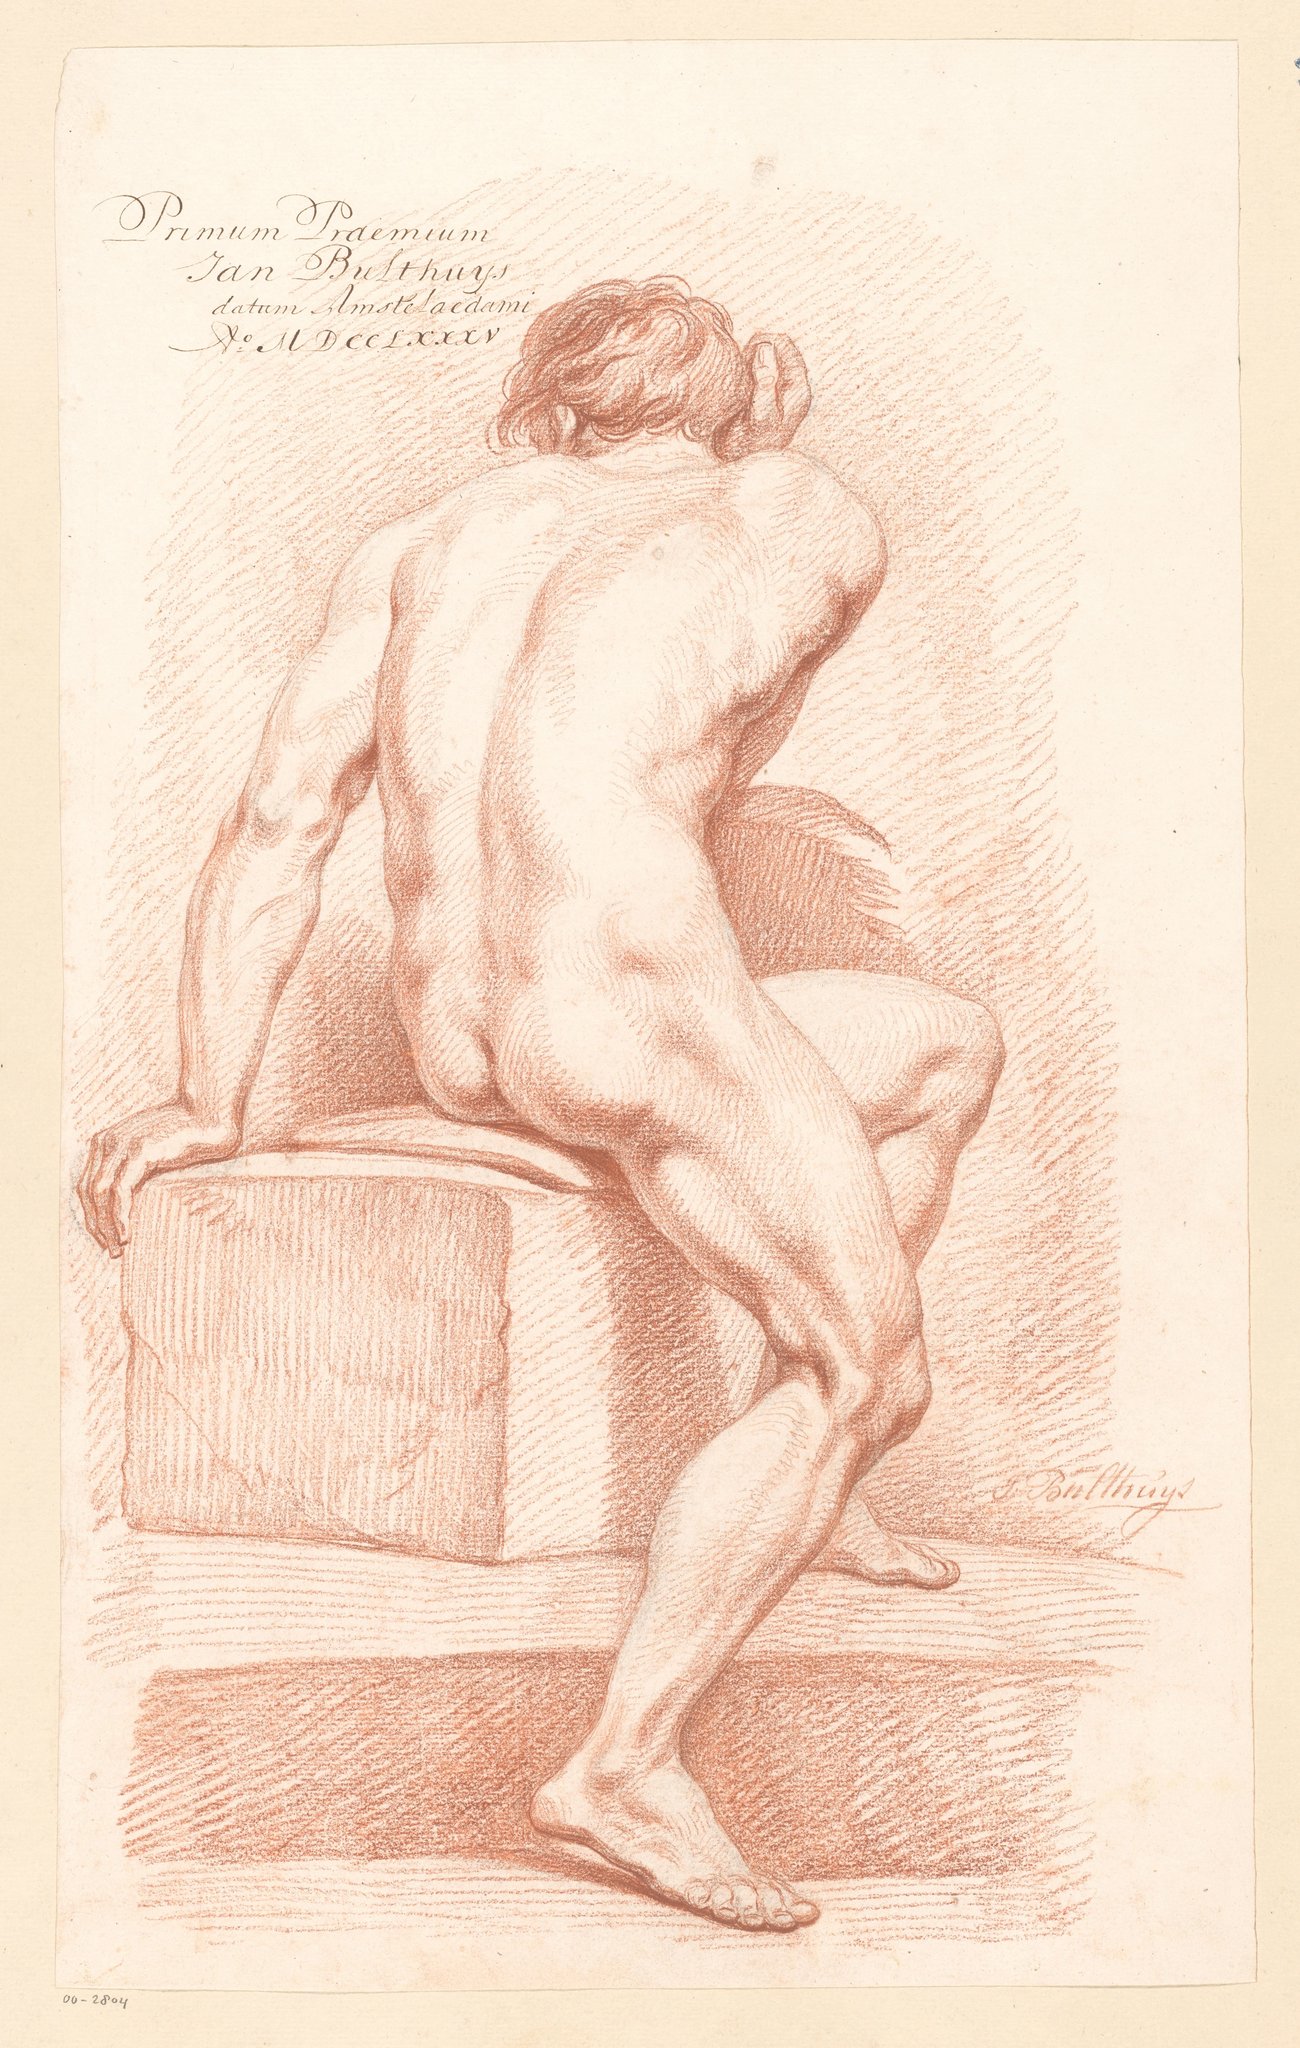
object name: drawing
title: Zittend mannelijk naakt, op de rug gezien (1e prijs 1785)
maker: jan bulthuis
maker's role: draughtsman, print maker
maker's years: 1750-1801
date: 1785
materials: chalk, charcoal, paper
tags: sitting figure (+ nude human being)